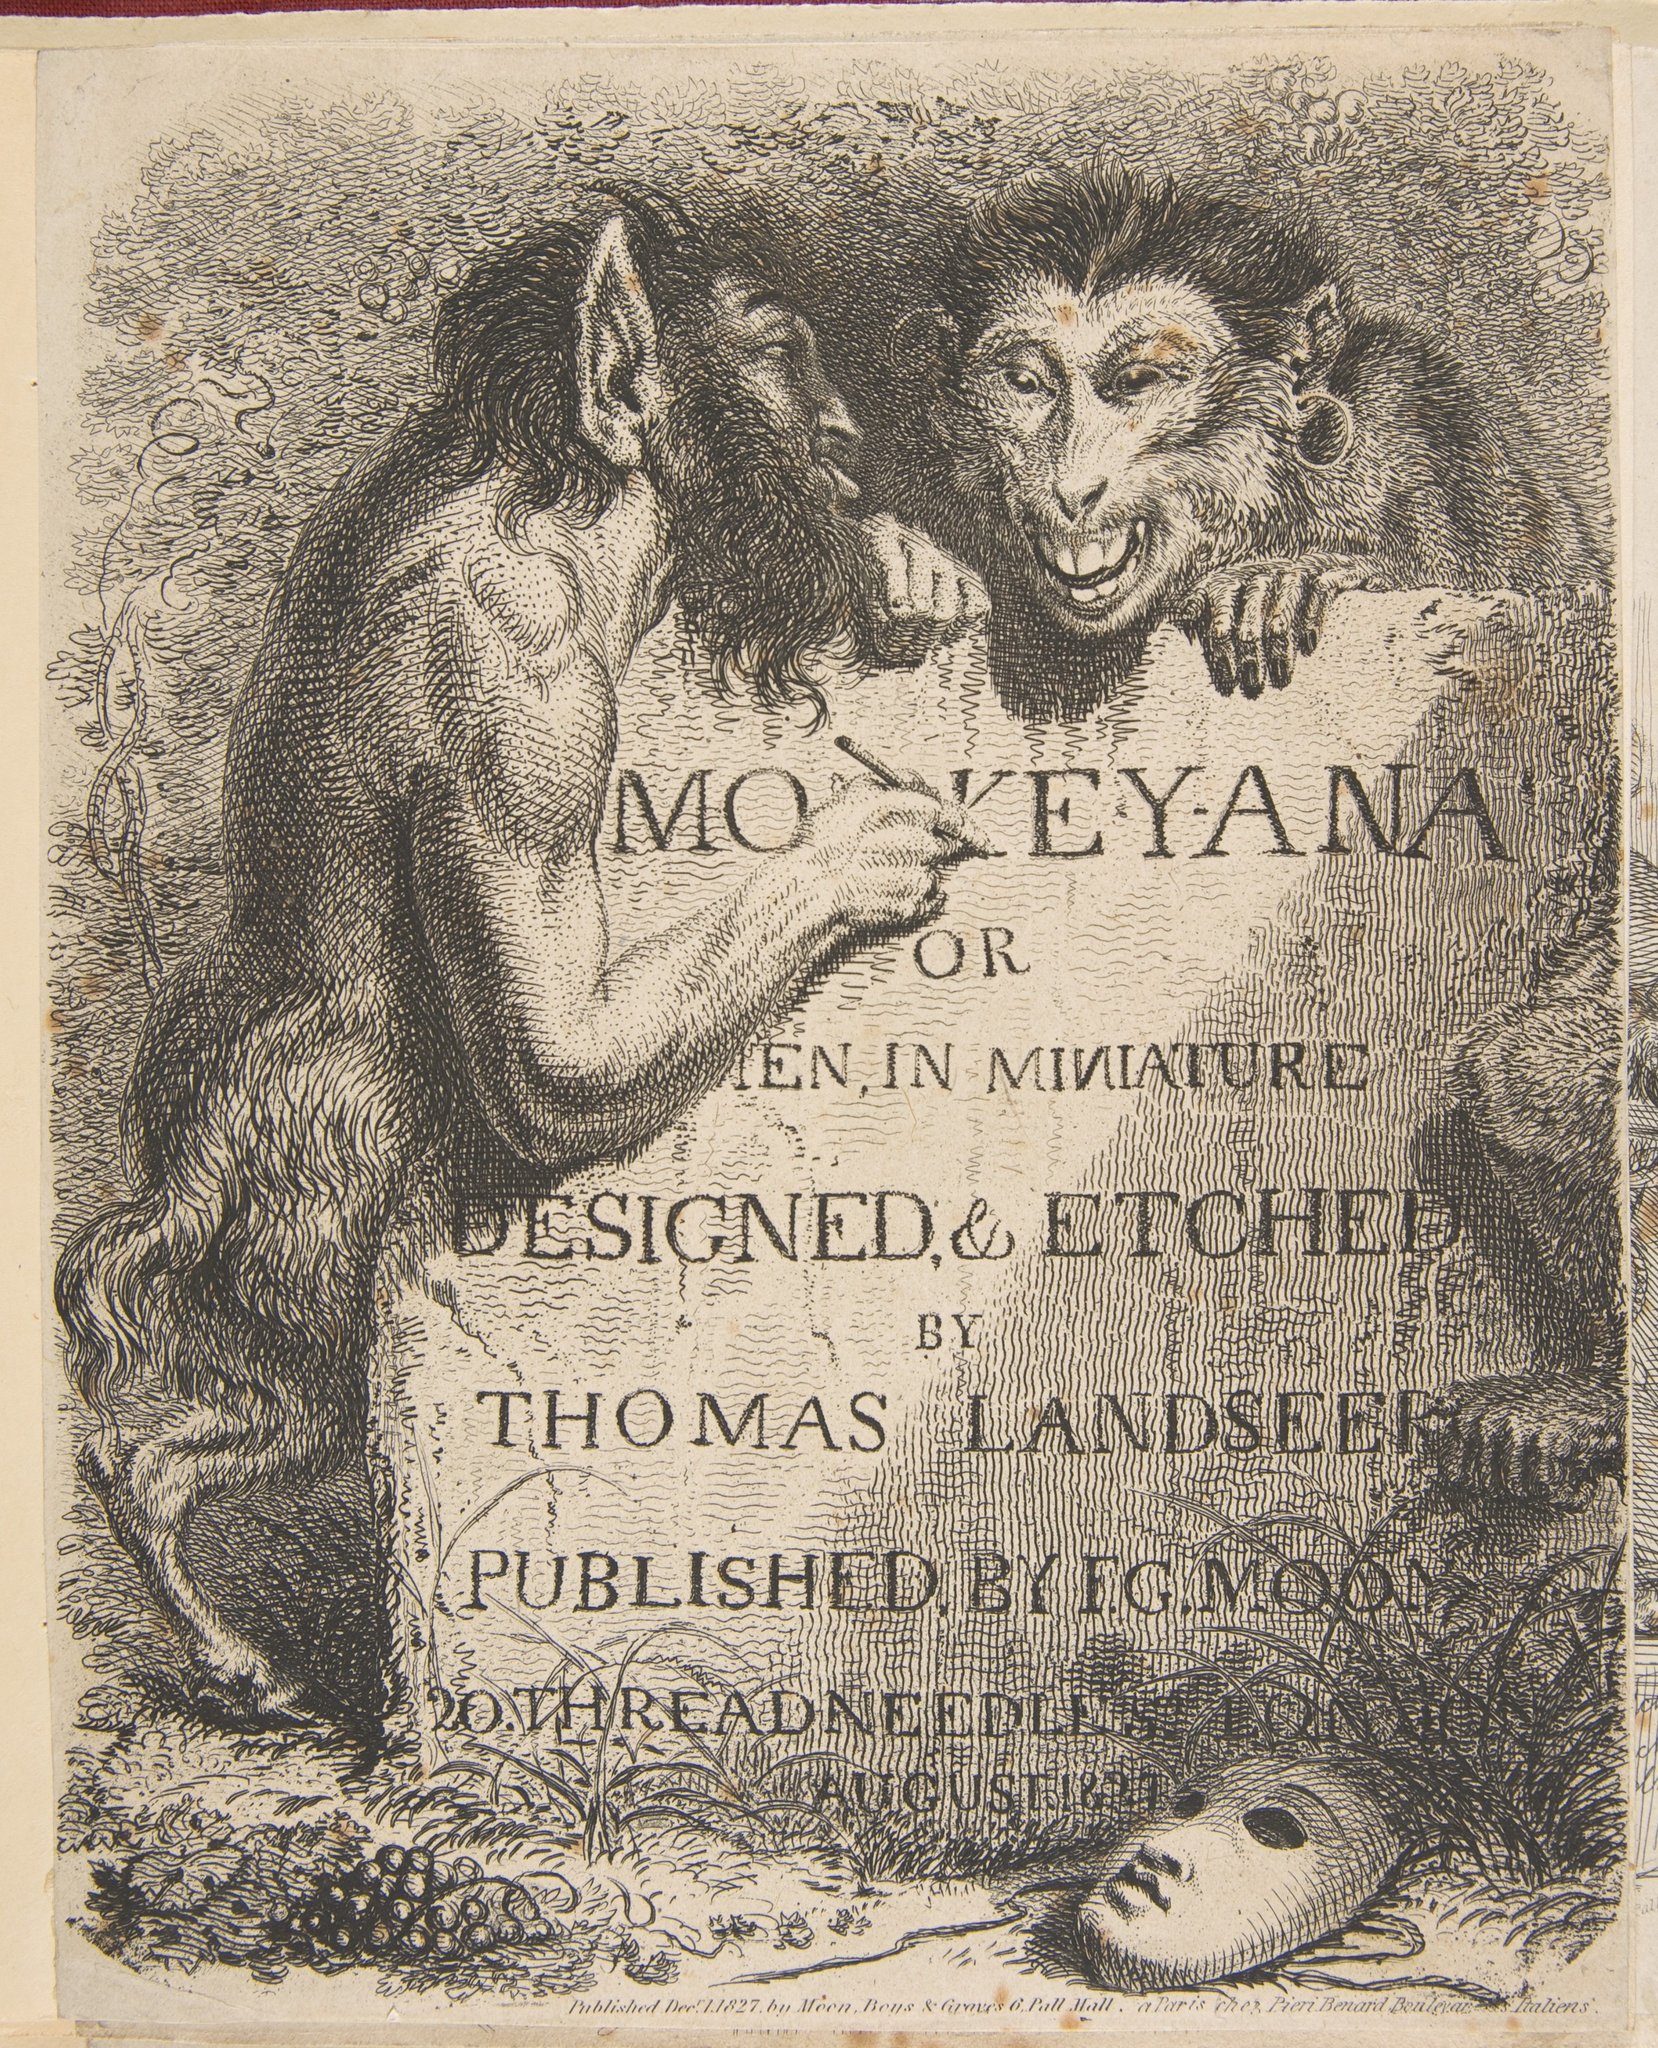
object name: print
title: Title Page: Monkey-Ana or Men, in Miniature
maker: thomas landseer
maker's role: artist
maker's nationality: british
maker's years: 1795-1880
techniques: etching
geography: france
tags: faces,monkeys